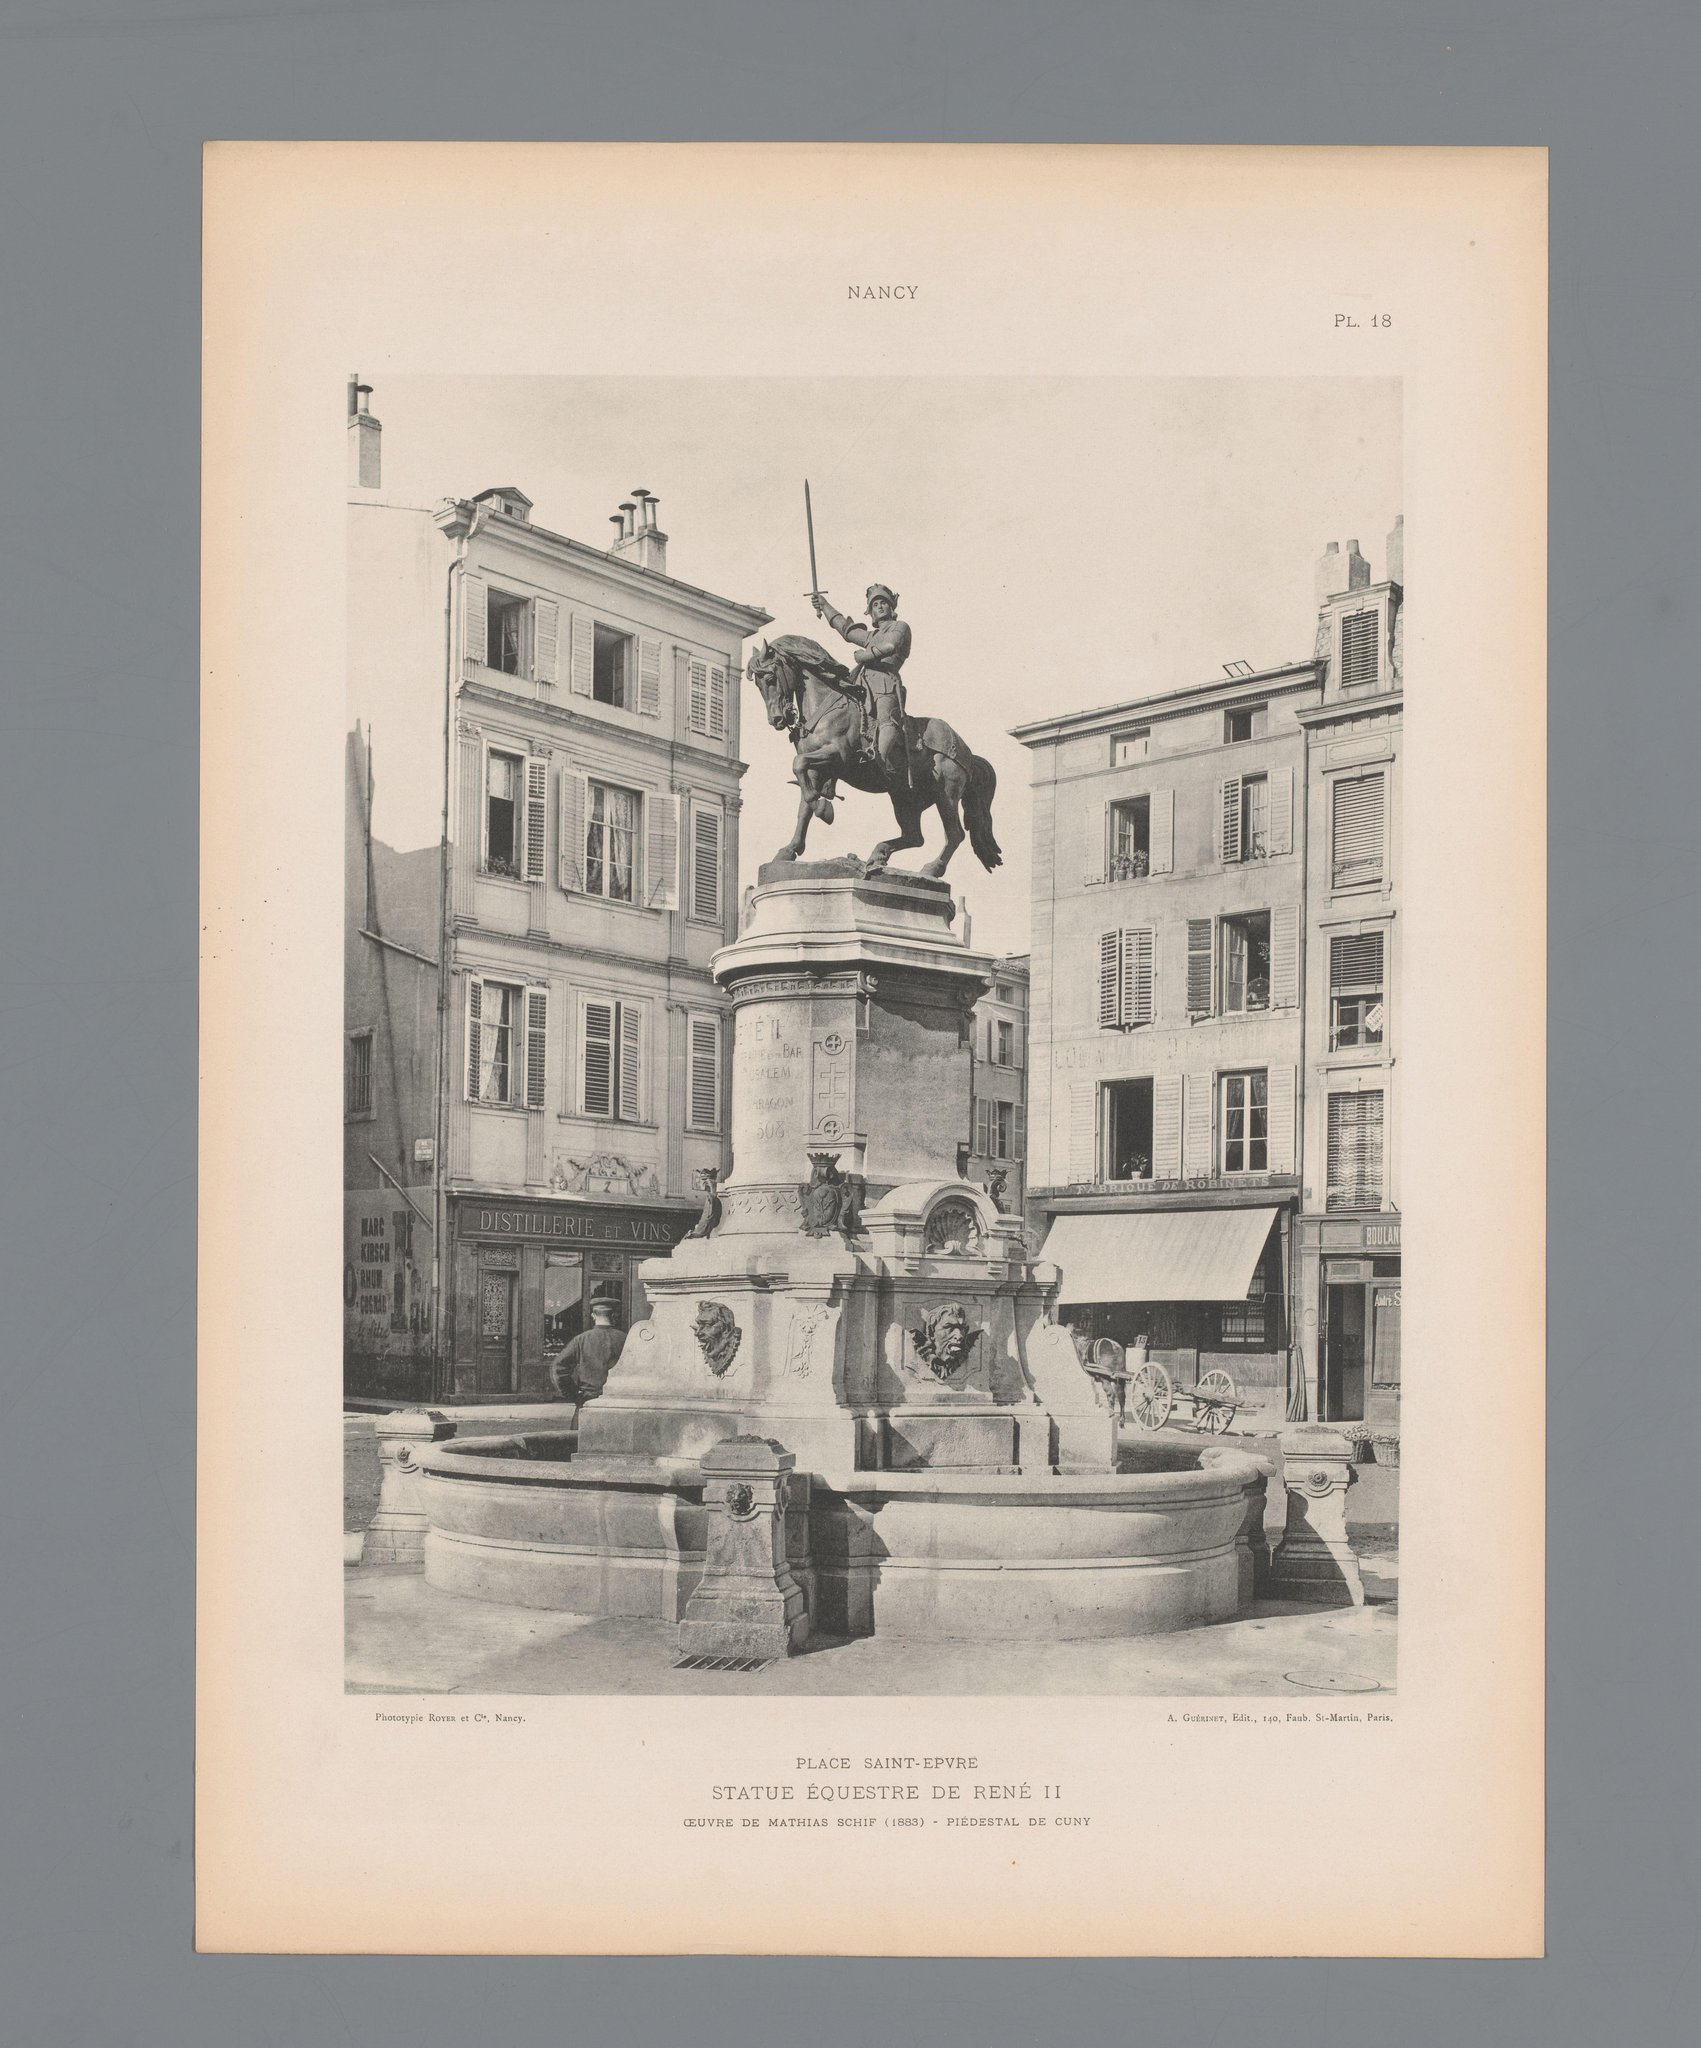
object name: photomechanical print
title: Standbeeld van René II van Lotharingen op Place Saint-Epvre te Nancy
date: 1891-1896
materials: paper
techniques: photograph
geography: nancy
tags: square, place, circus, etc., monument, statue (+ city(-scape) with figures, staffage)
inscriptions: inscription: ‘Place Saint-Epvre/ Statue Équestre de René II (...)’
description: Deze prent maakt deel uit van een omslag met 103 prenten op 101 bladen en een titelblad.